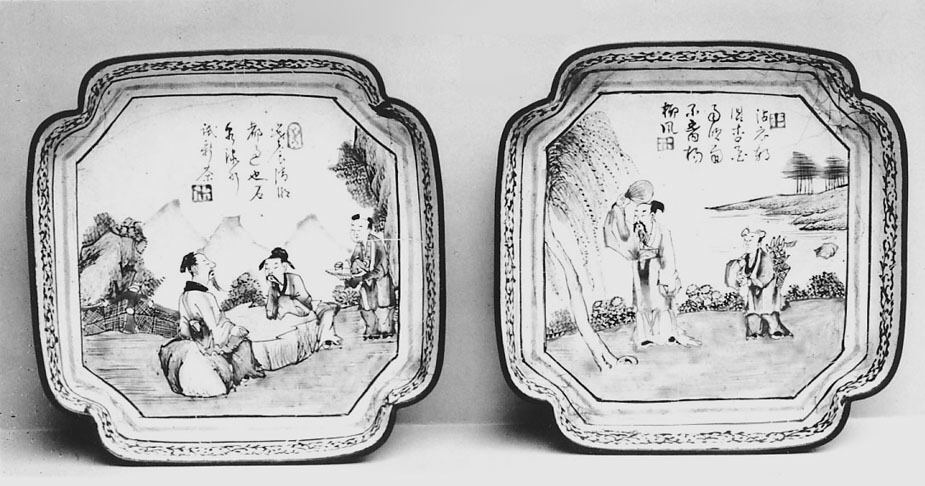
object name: dish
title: Square Dish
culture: chinese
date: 1801-1900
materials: enamel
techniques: painting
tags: men,plants